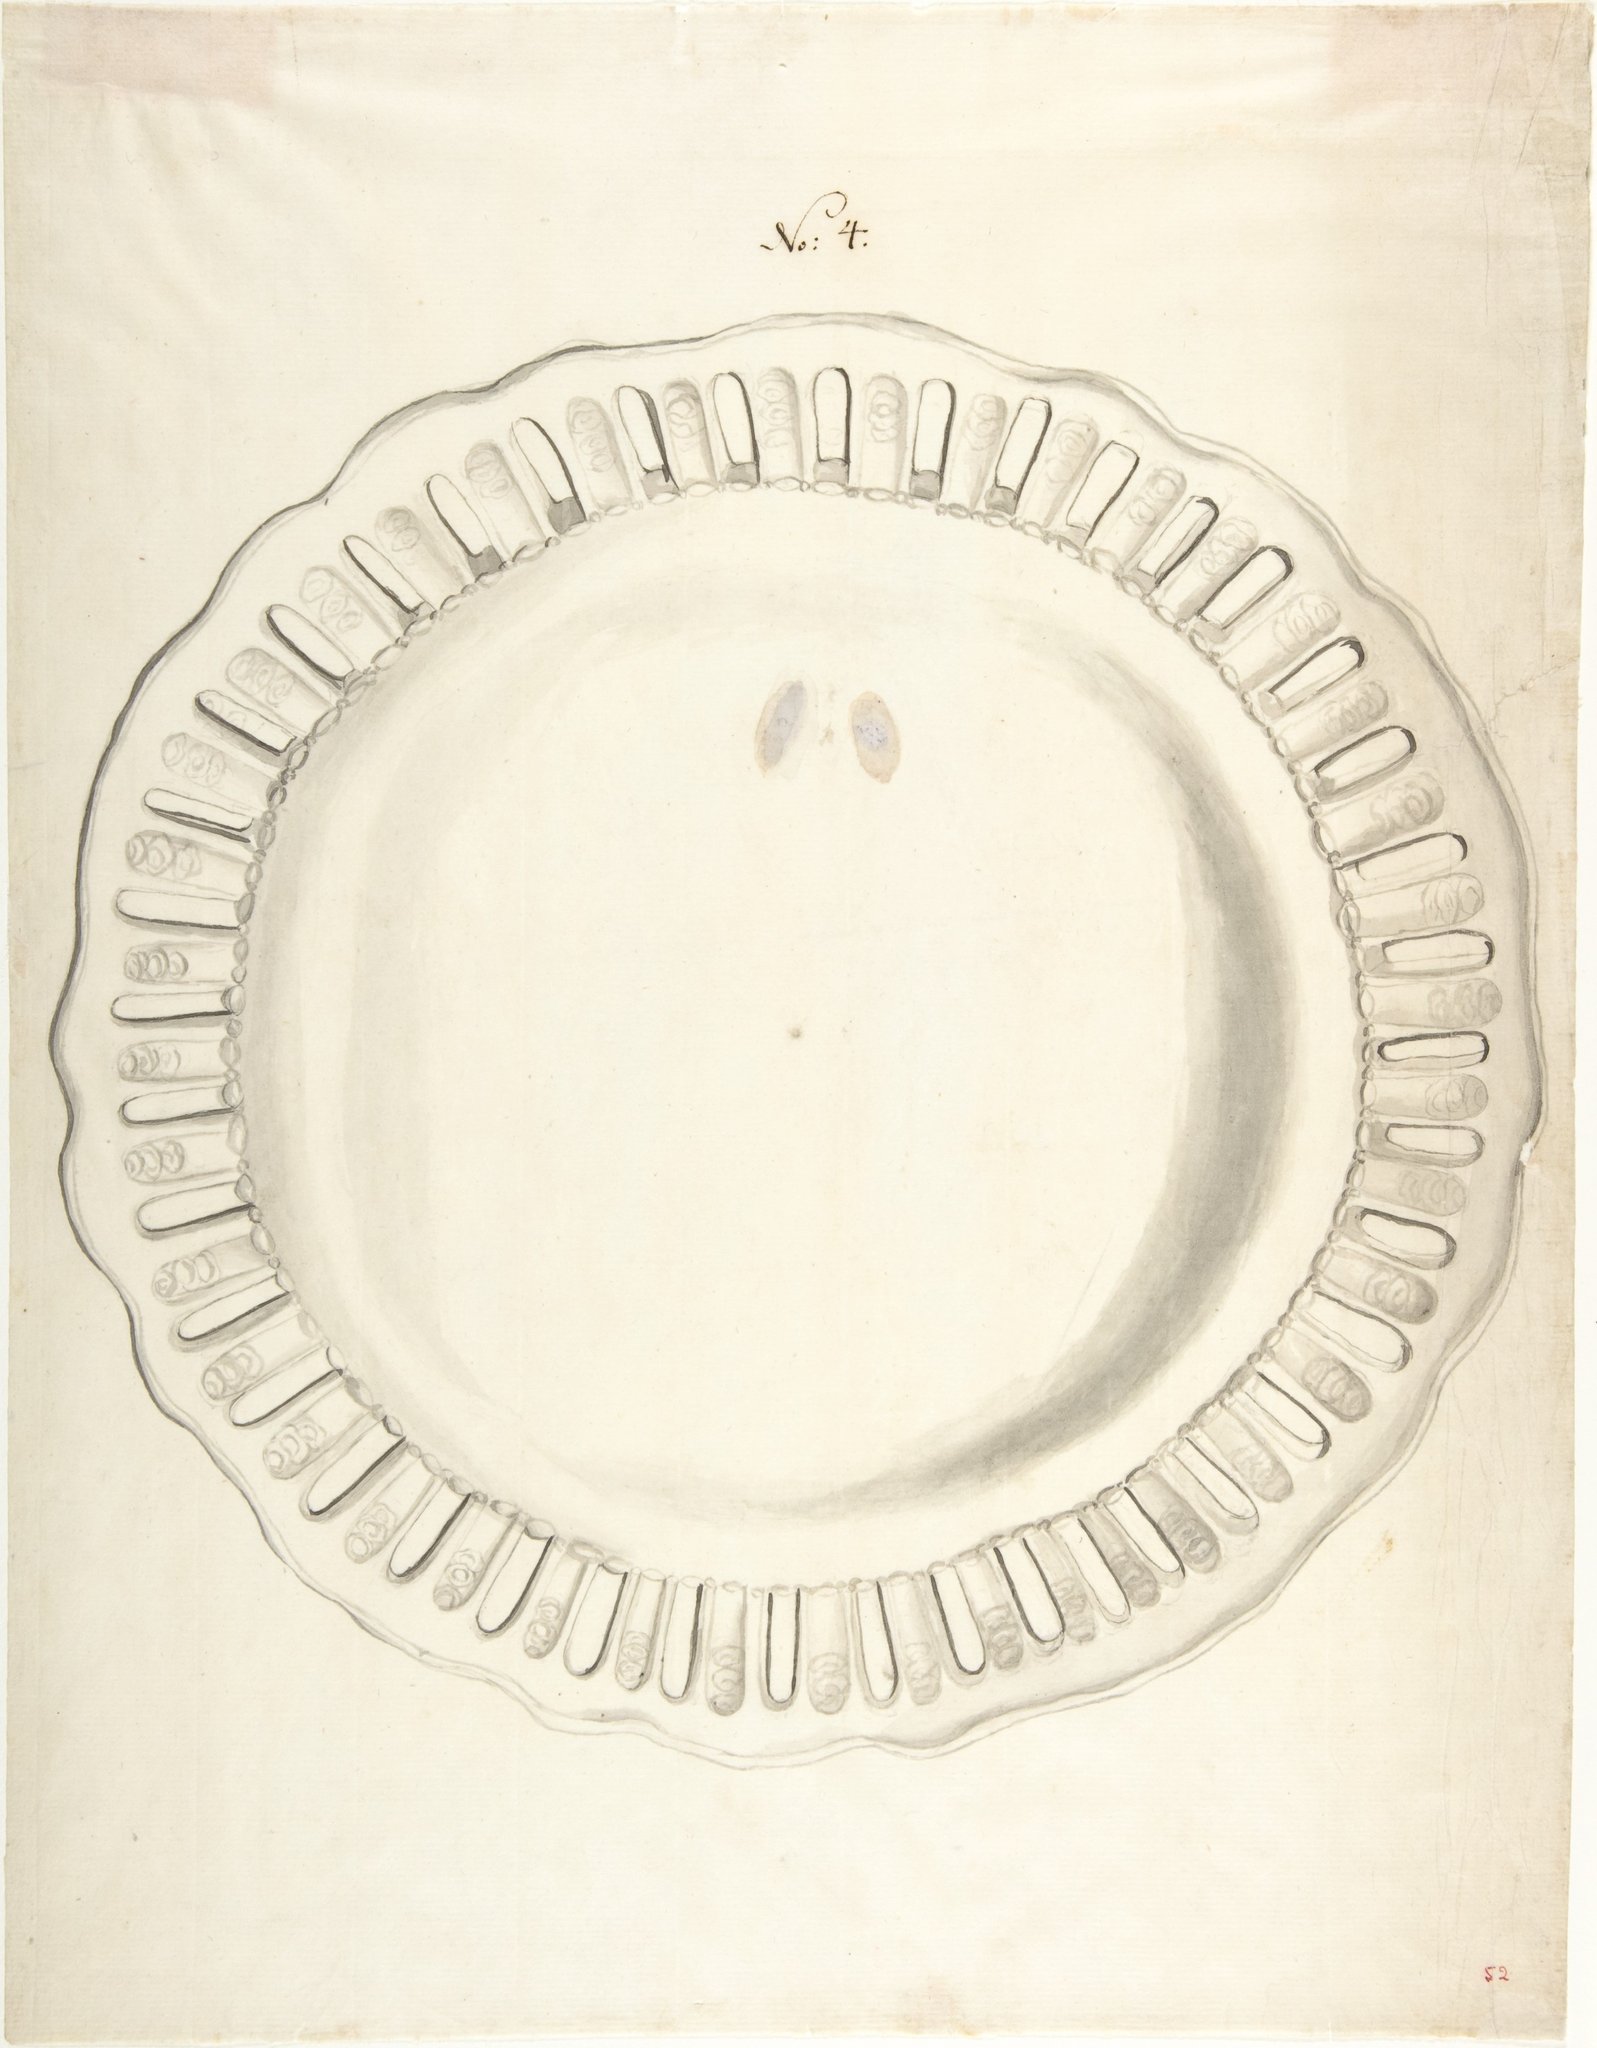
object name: drawing ornament architecture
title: Design for a Plate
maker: anonymous, french, 18th century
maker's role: artist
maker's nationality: french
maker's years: 1700-1800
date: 1770-1790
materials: ink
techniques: brush, pen, wash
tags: dishes